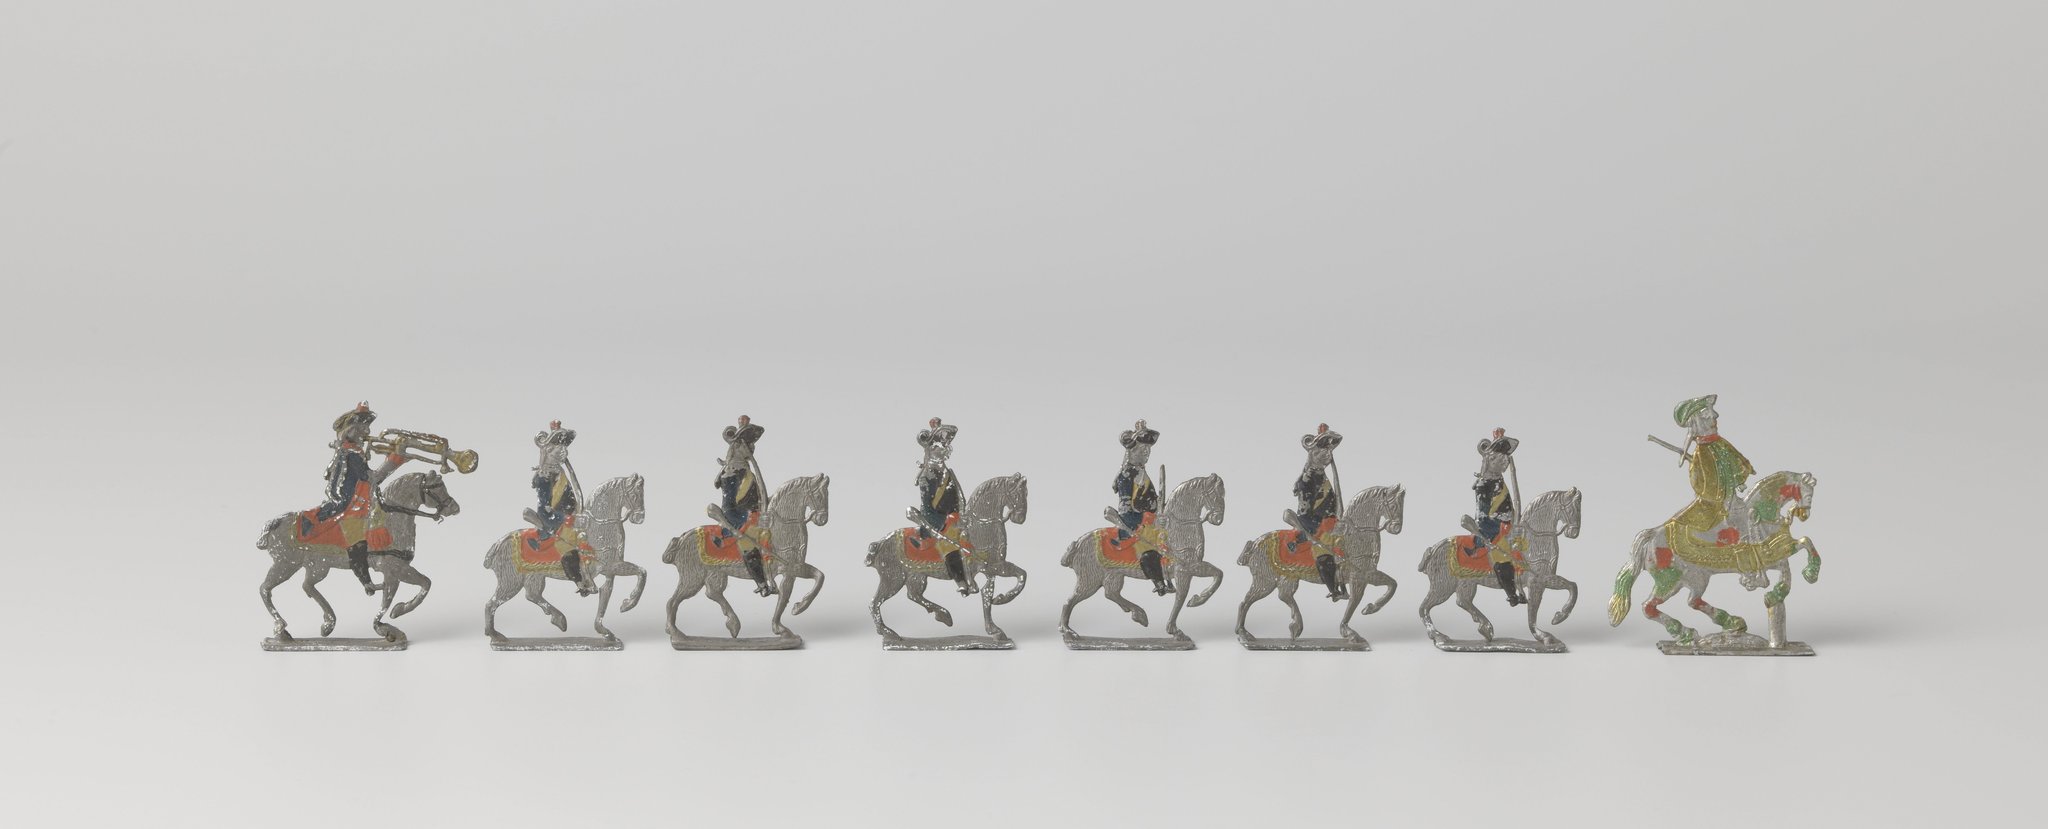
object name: toy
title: Ruiters te paard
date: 1775-1800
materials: paint, tin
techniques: casting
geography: europe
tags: riding a horse, ass, or mule; rider, horseman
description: Negen tinnen figuren van ruiters te paard, voorzien van willekeurig aangebrachte vlekken rode, groene en goudkleurige verf. Ze vormen een optocht.